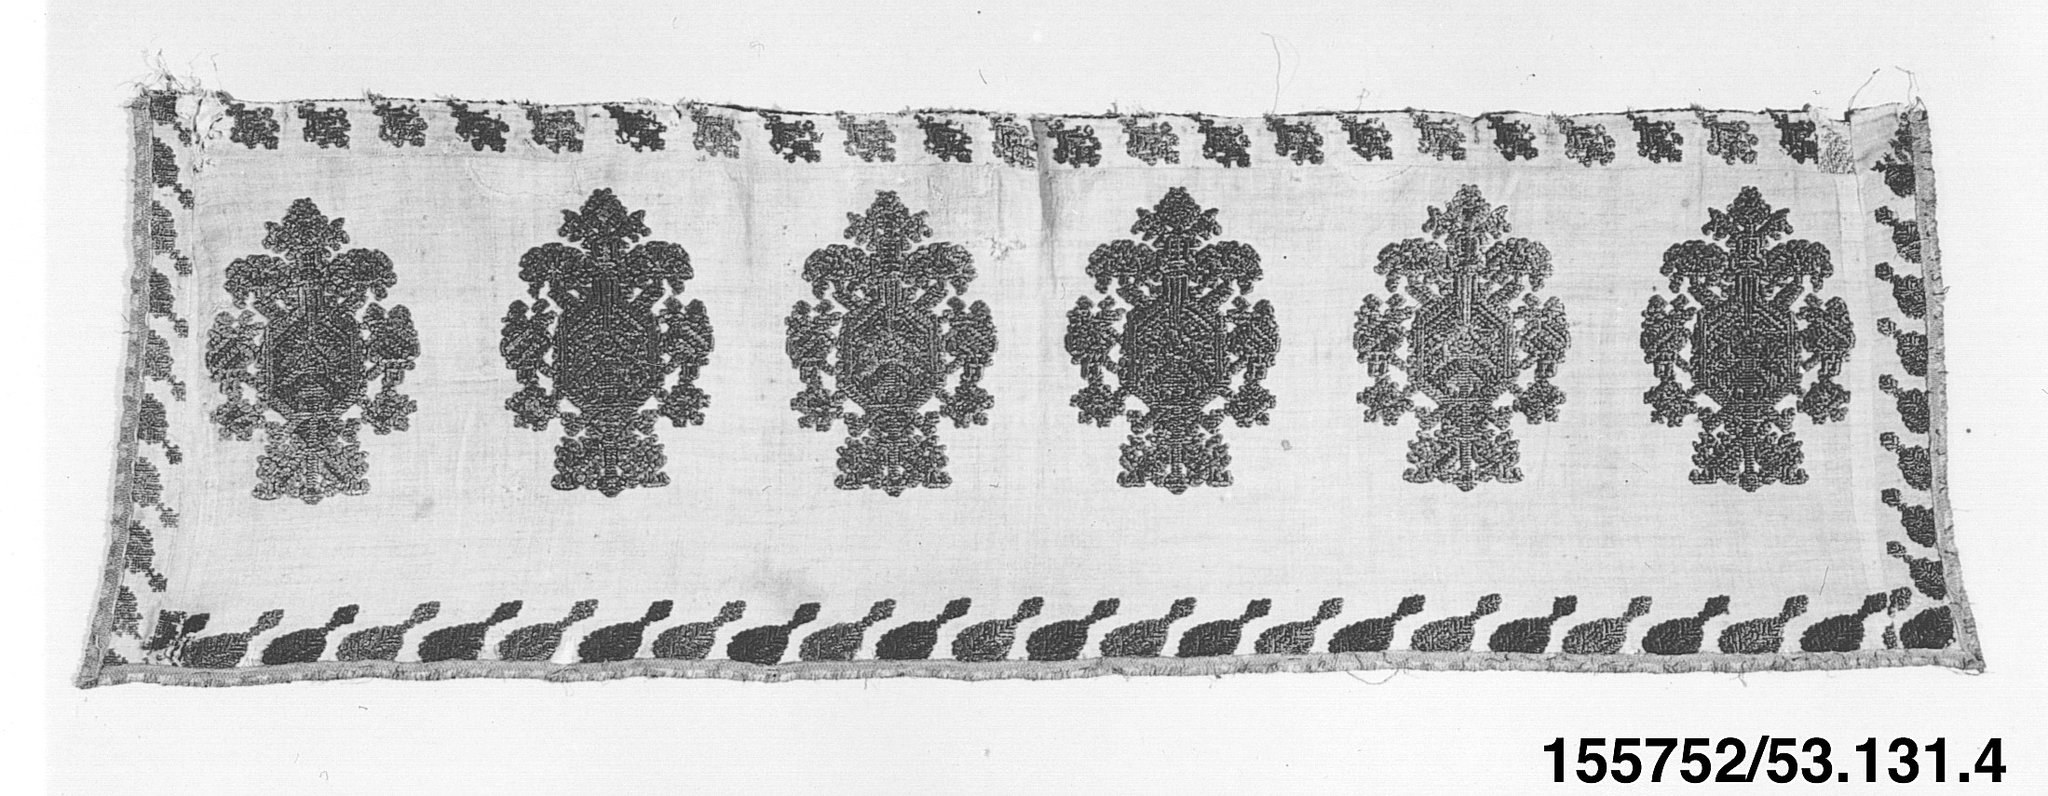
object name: valance fragment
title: Piece of valance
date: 1701-1800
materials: linen, silk